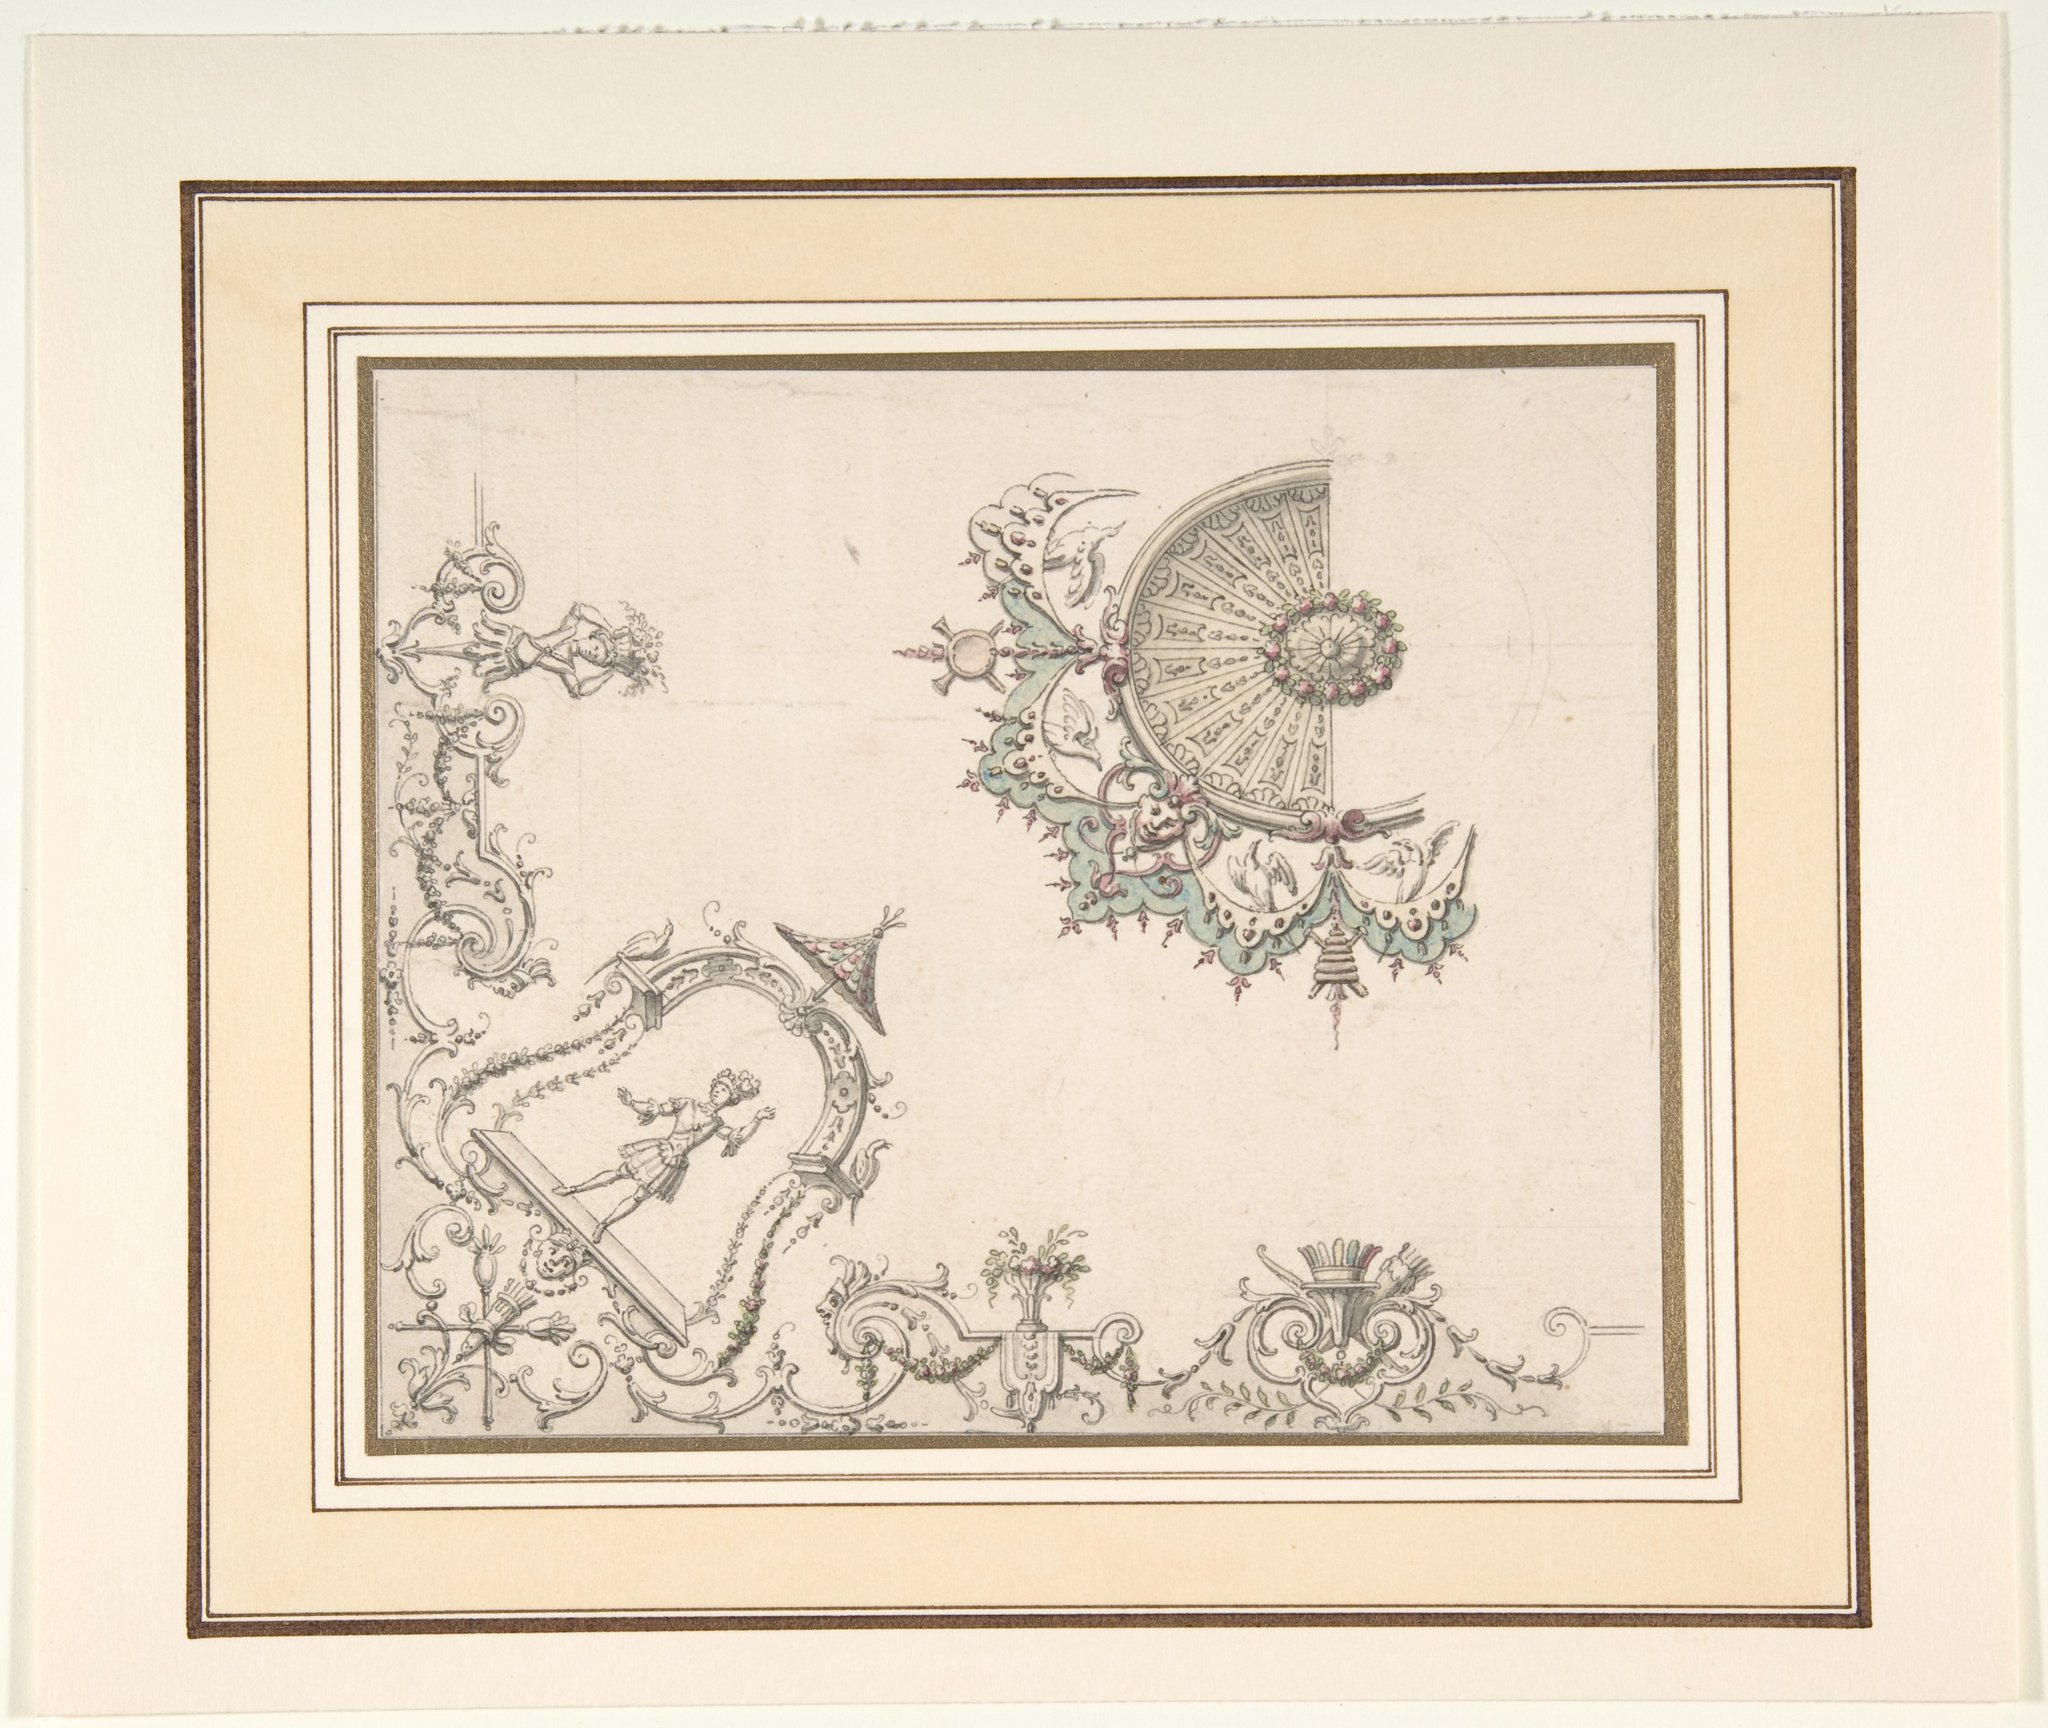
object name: drawing ornament architecture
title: Design for the Decoration of a Ceiling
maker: claude audran iii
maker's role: artist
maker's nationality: french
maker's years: 1658-1734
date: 1658-1734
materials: ink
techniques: brush, pen, wash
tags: birds,women